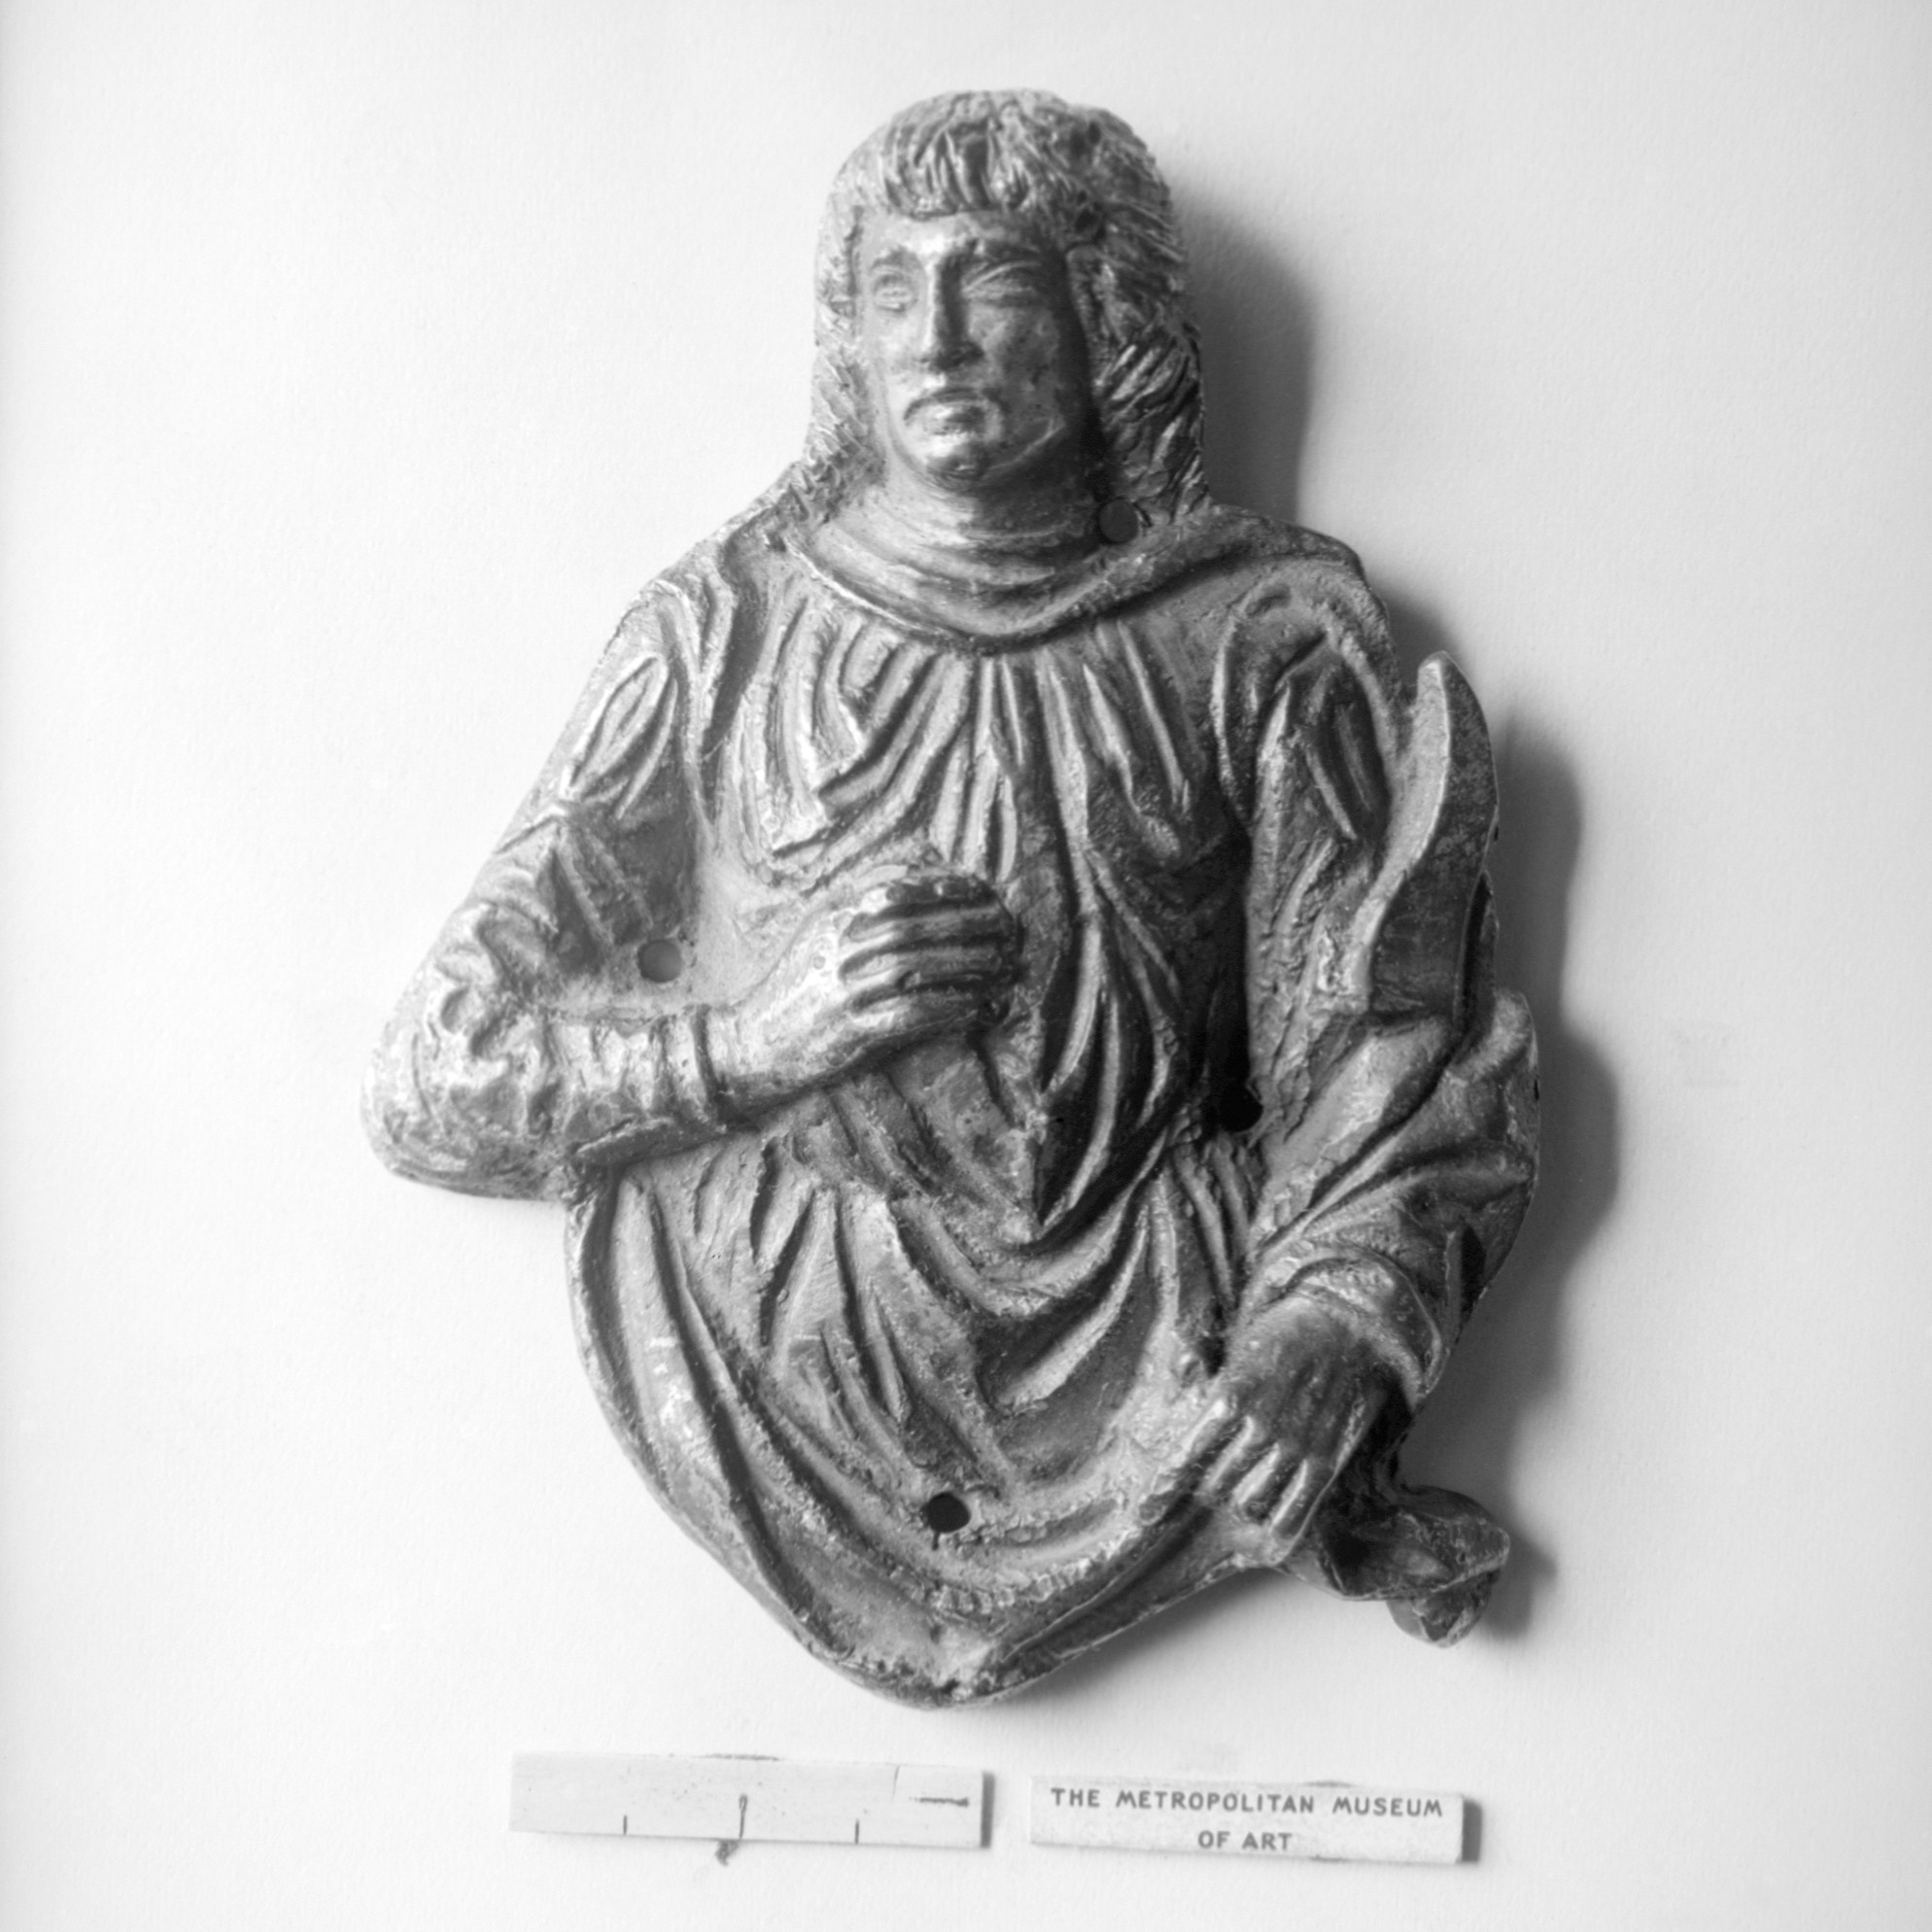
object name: plaquette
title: Male saint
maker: francesco marti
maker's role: artist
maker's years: 1489-1516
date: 1501-1533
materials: gilt bronze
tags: men,saints